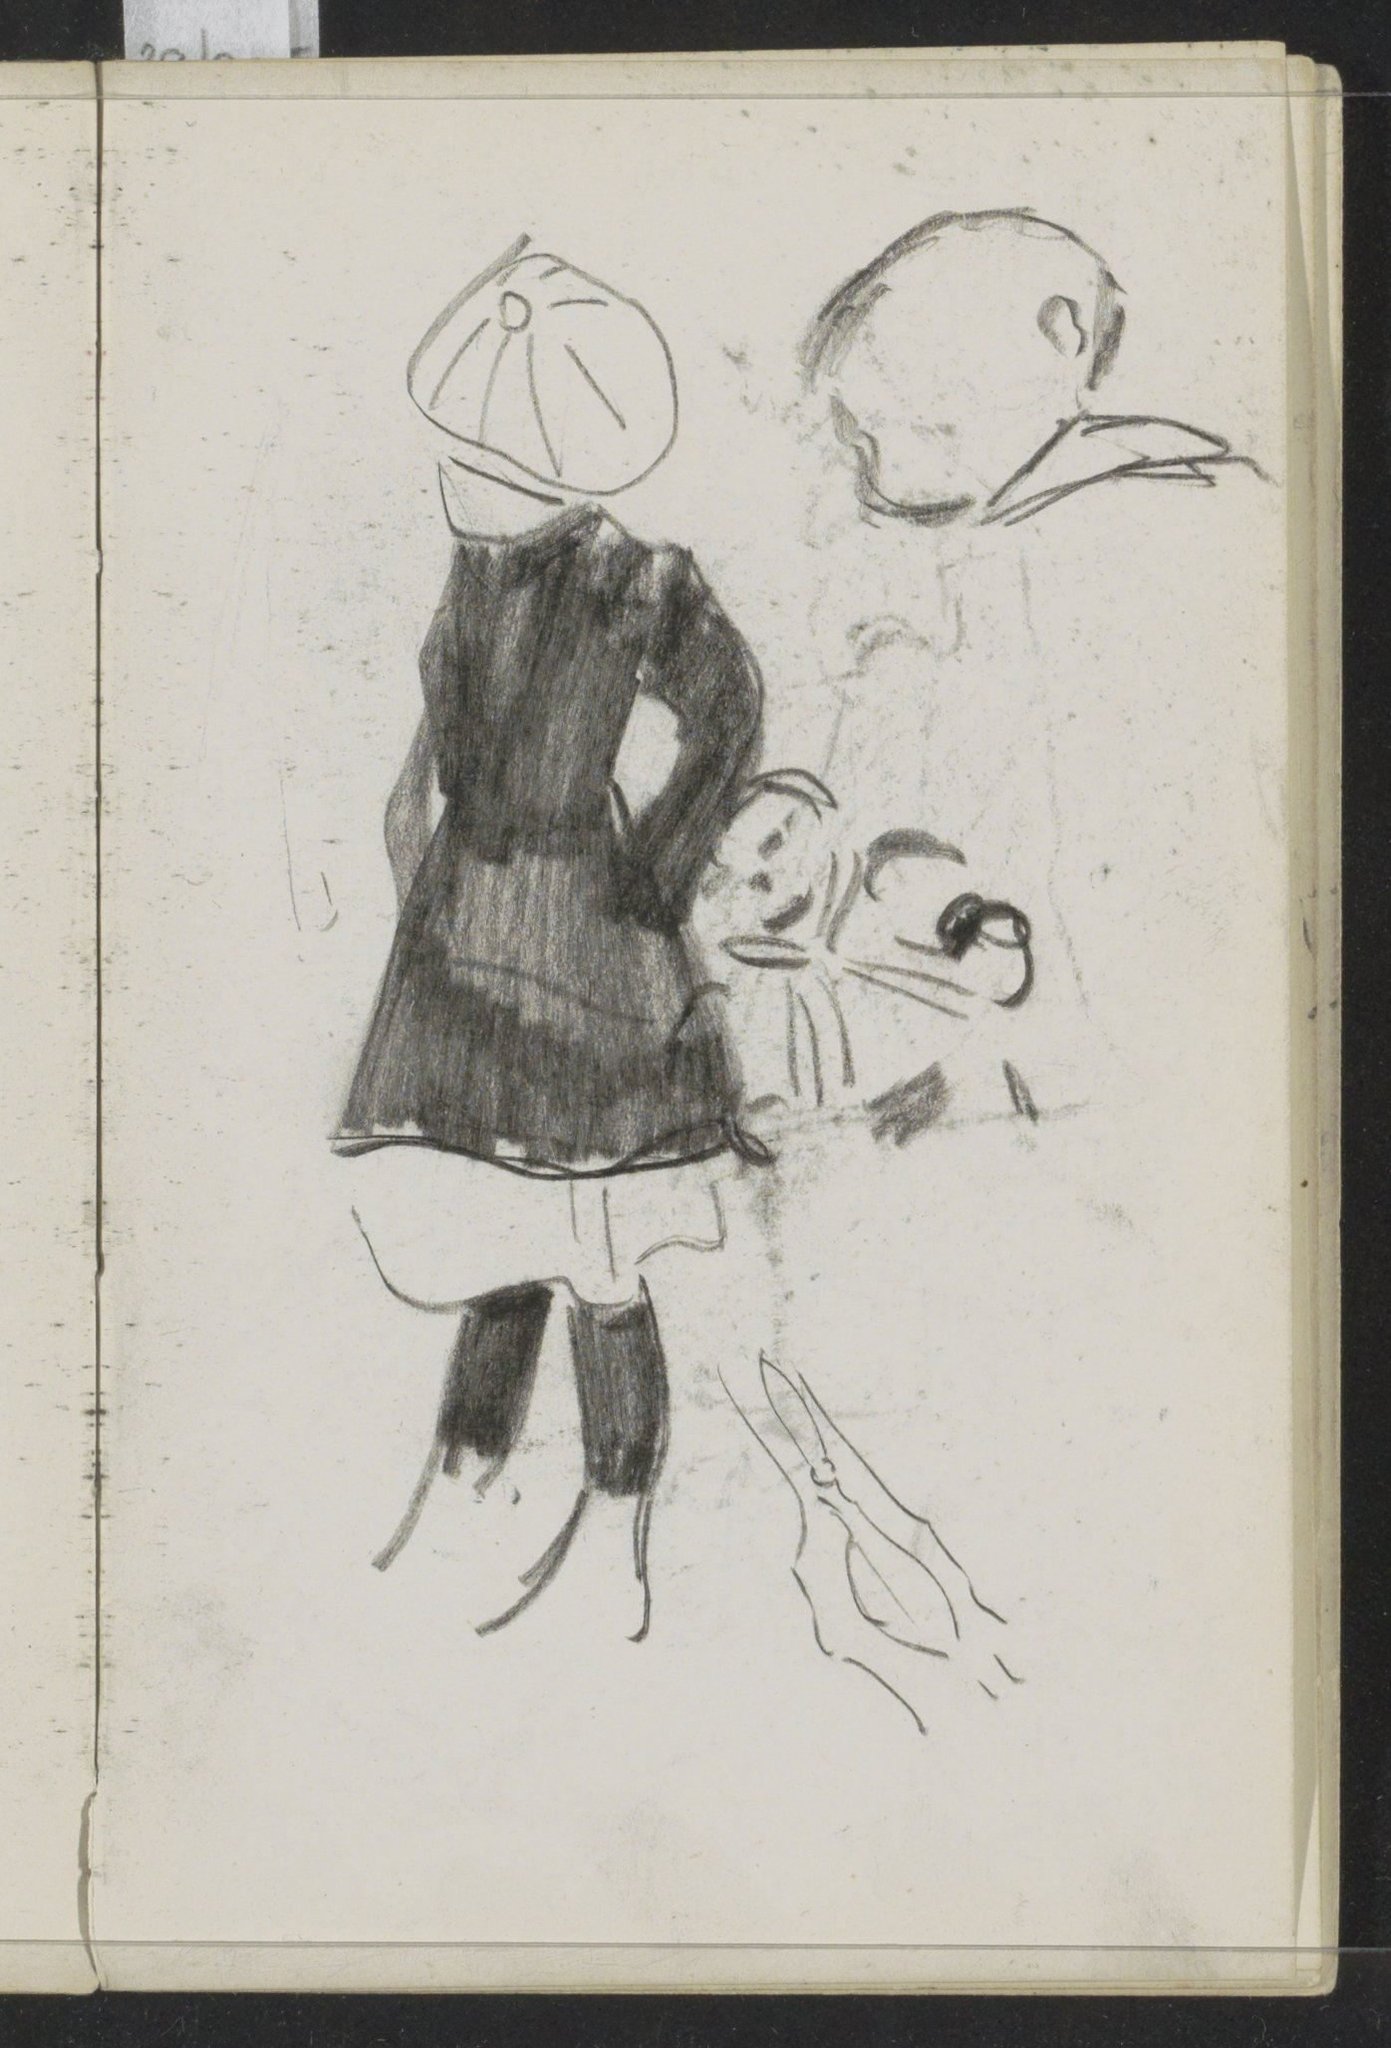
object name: sketchbook leaf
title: Figuur in een jurk en mantel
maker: carel adolph lion cachet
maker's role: draughtsman, print maker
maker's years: 1864-1945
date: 1874-1945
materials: chalk, paper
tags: coat, dress, gown (+ women's clothes), girl (child between toddler and youth)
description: Tevens een studie van een pet en een kop van een kind. Blad 27 recto uit een schetsboek met 41 bladen.